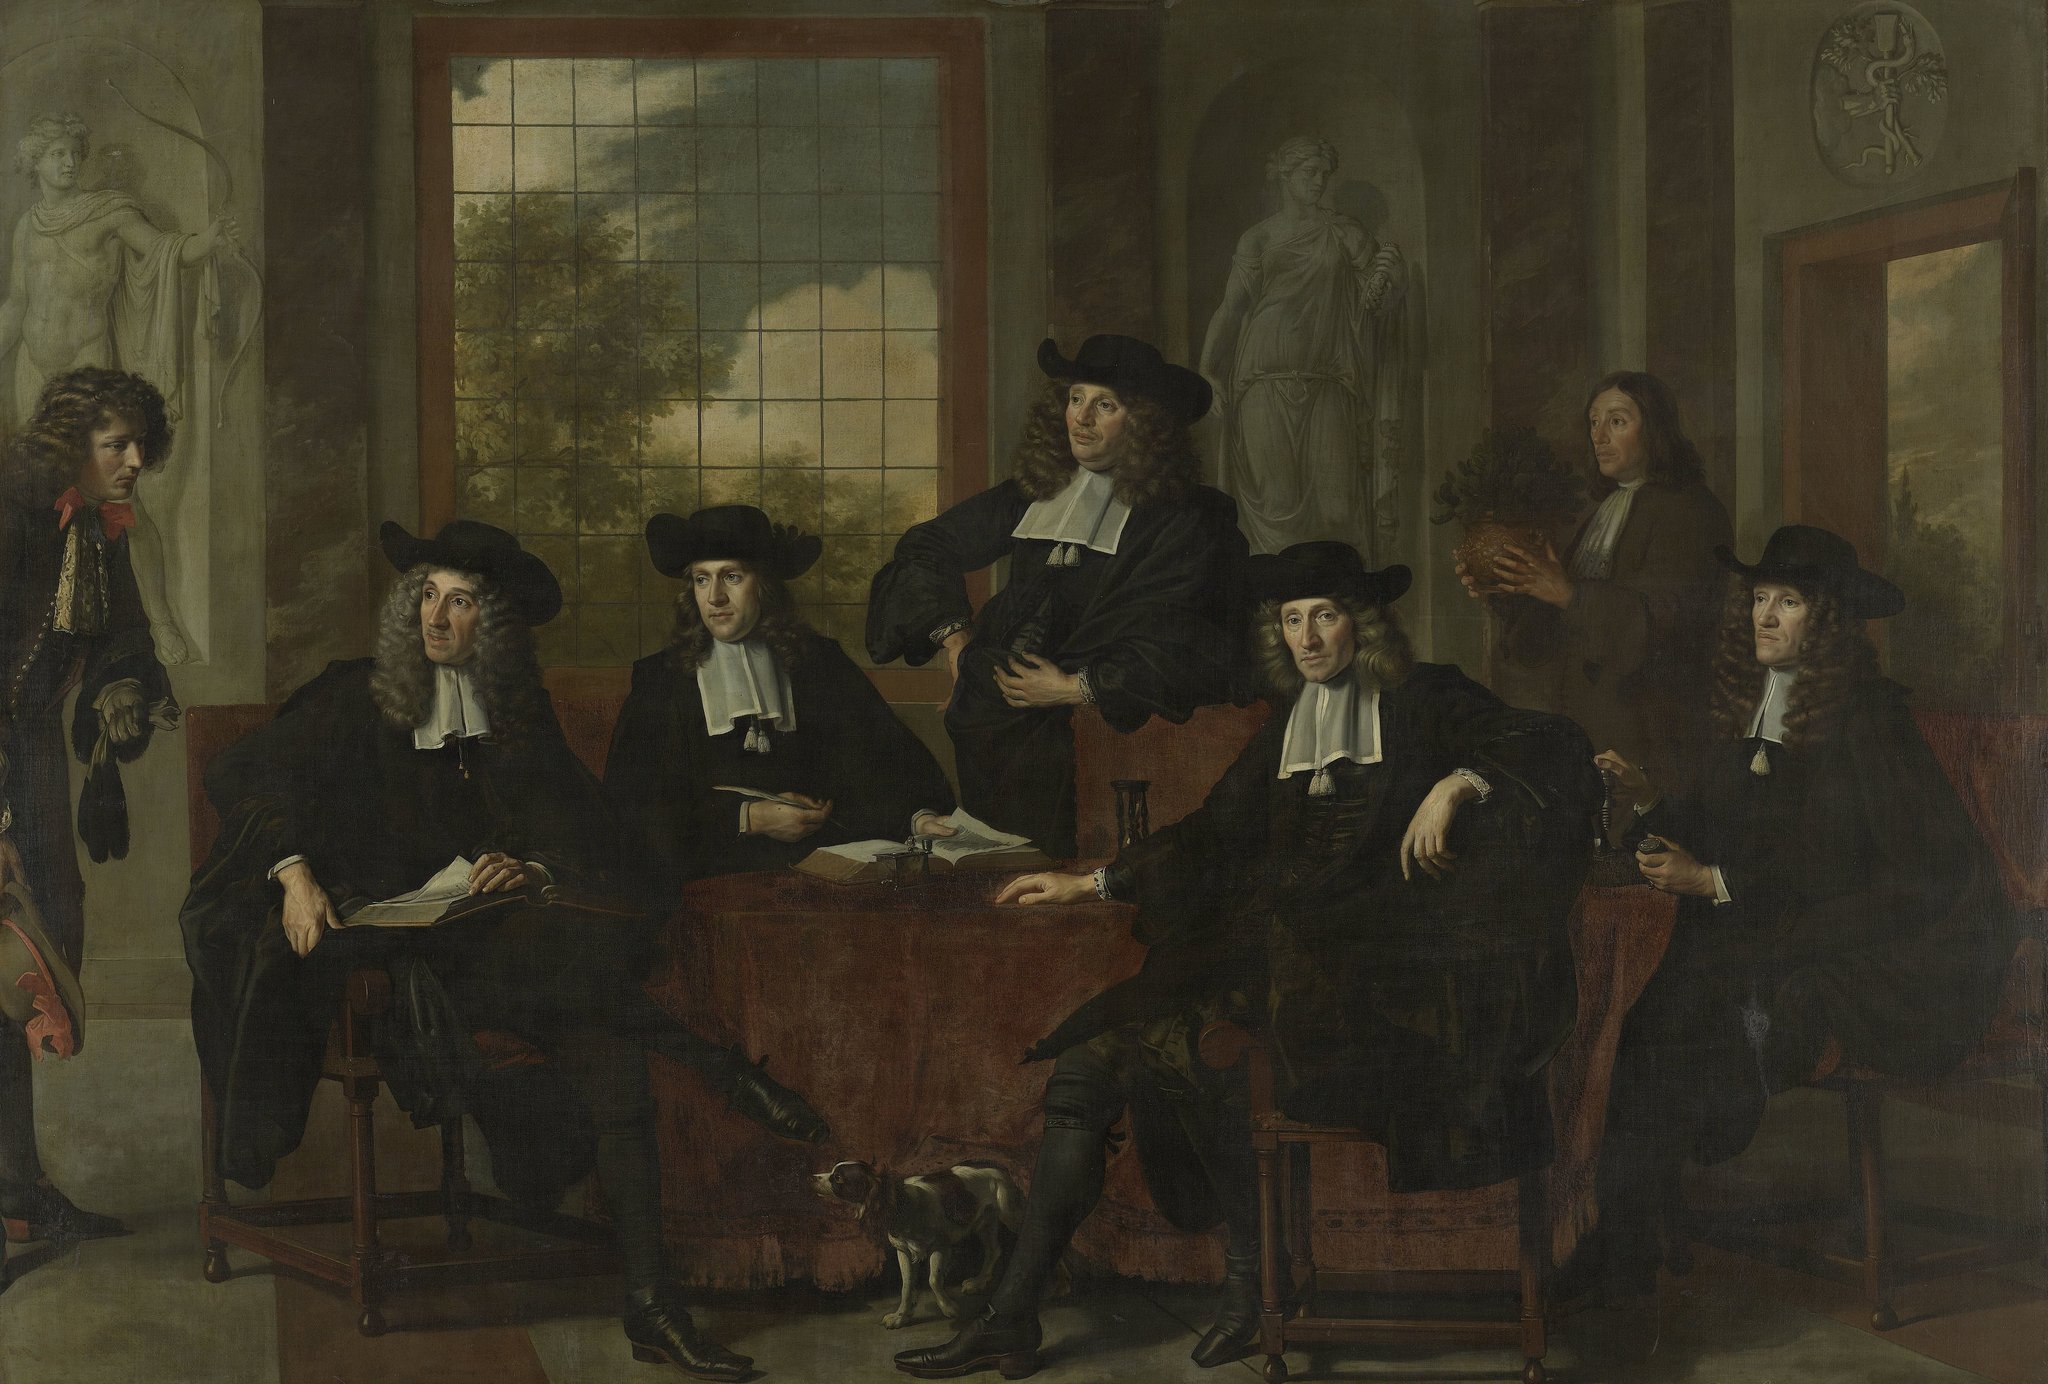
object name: painting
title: The Superintendents of the Collegium Medicum in Amsterdam, 1683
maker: adriaen backer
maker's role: draughtsman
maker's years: 1635-1684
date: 1683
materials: canvas, oil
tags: historical persons, officers trusted with control of quality, medicine, medical science, amsterdam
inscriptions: signature and date: ‘ABacker 1683’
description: Groepsportret van de inspecteurs van het Collegium Medicum te Amsterdam, 1683. Links de gildeknecht Sieuwert van Duynen. Aan de tafel de doctoren Egbertus Veen, Bonaventura van Dortmont en Joan Verwout en de apothekers Johannes de Vriest, zijn zoon en Jacobus Danckertsz. de Ry. Op de muur voorstellingen van Apollo en een godin.